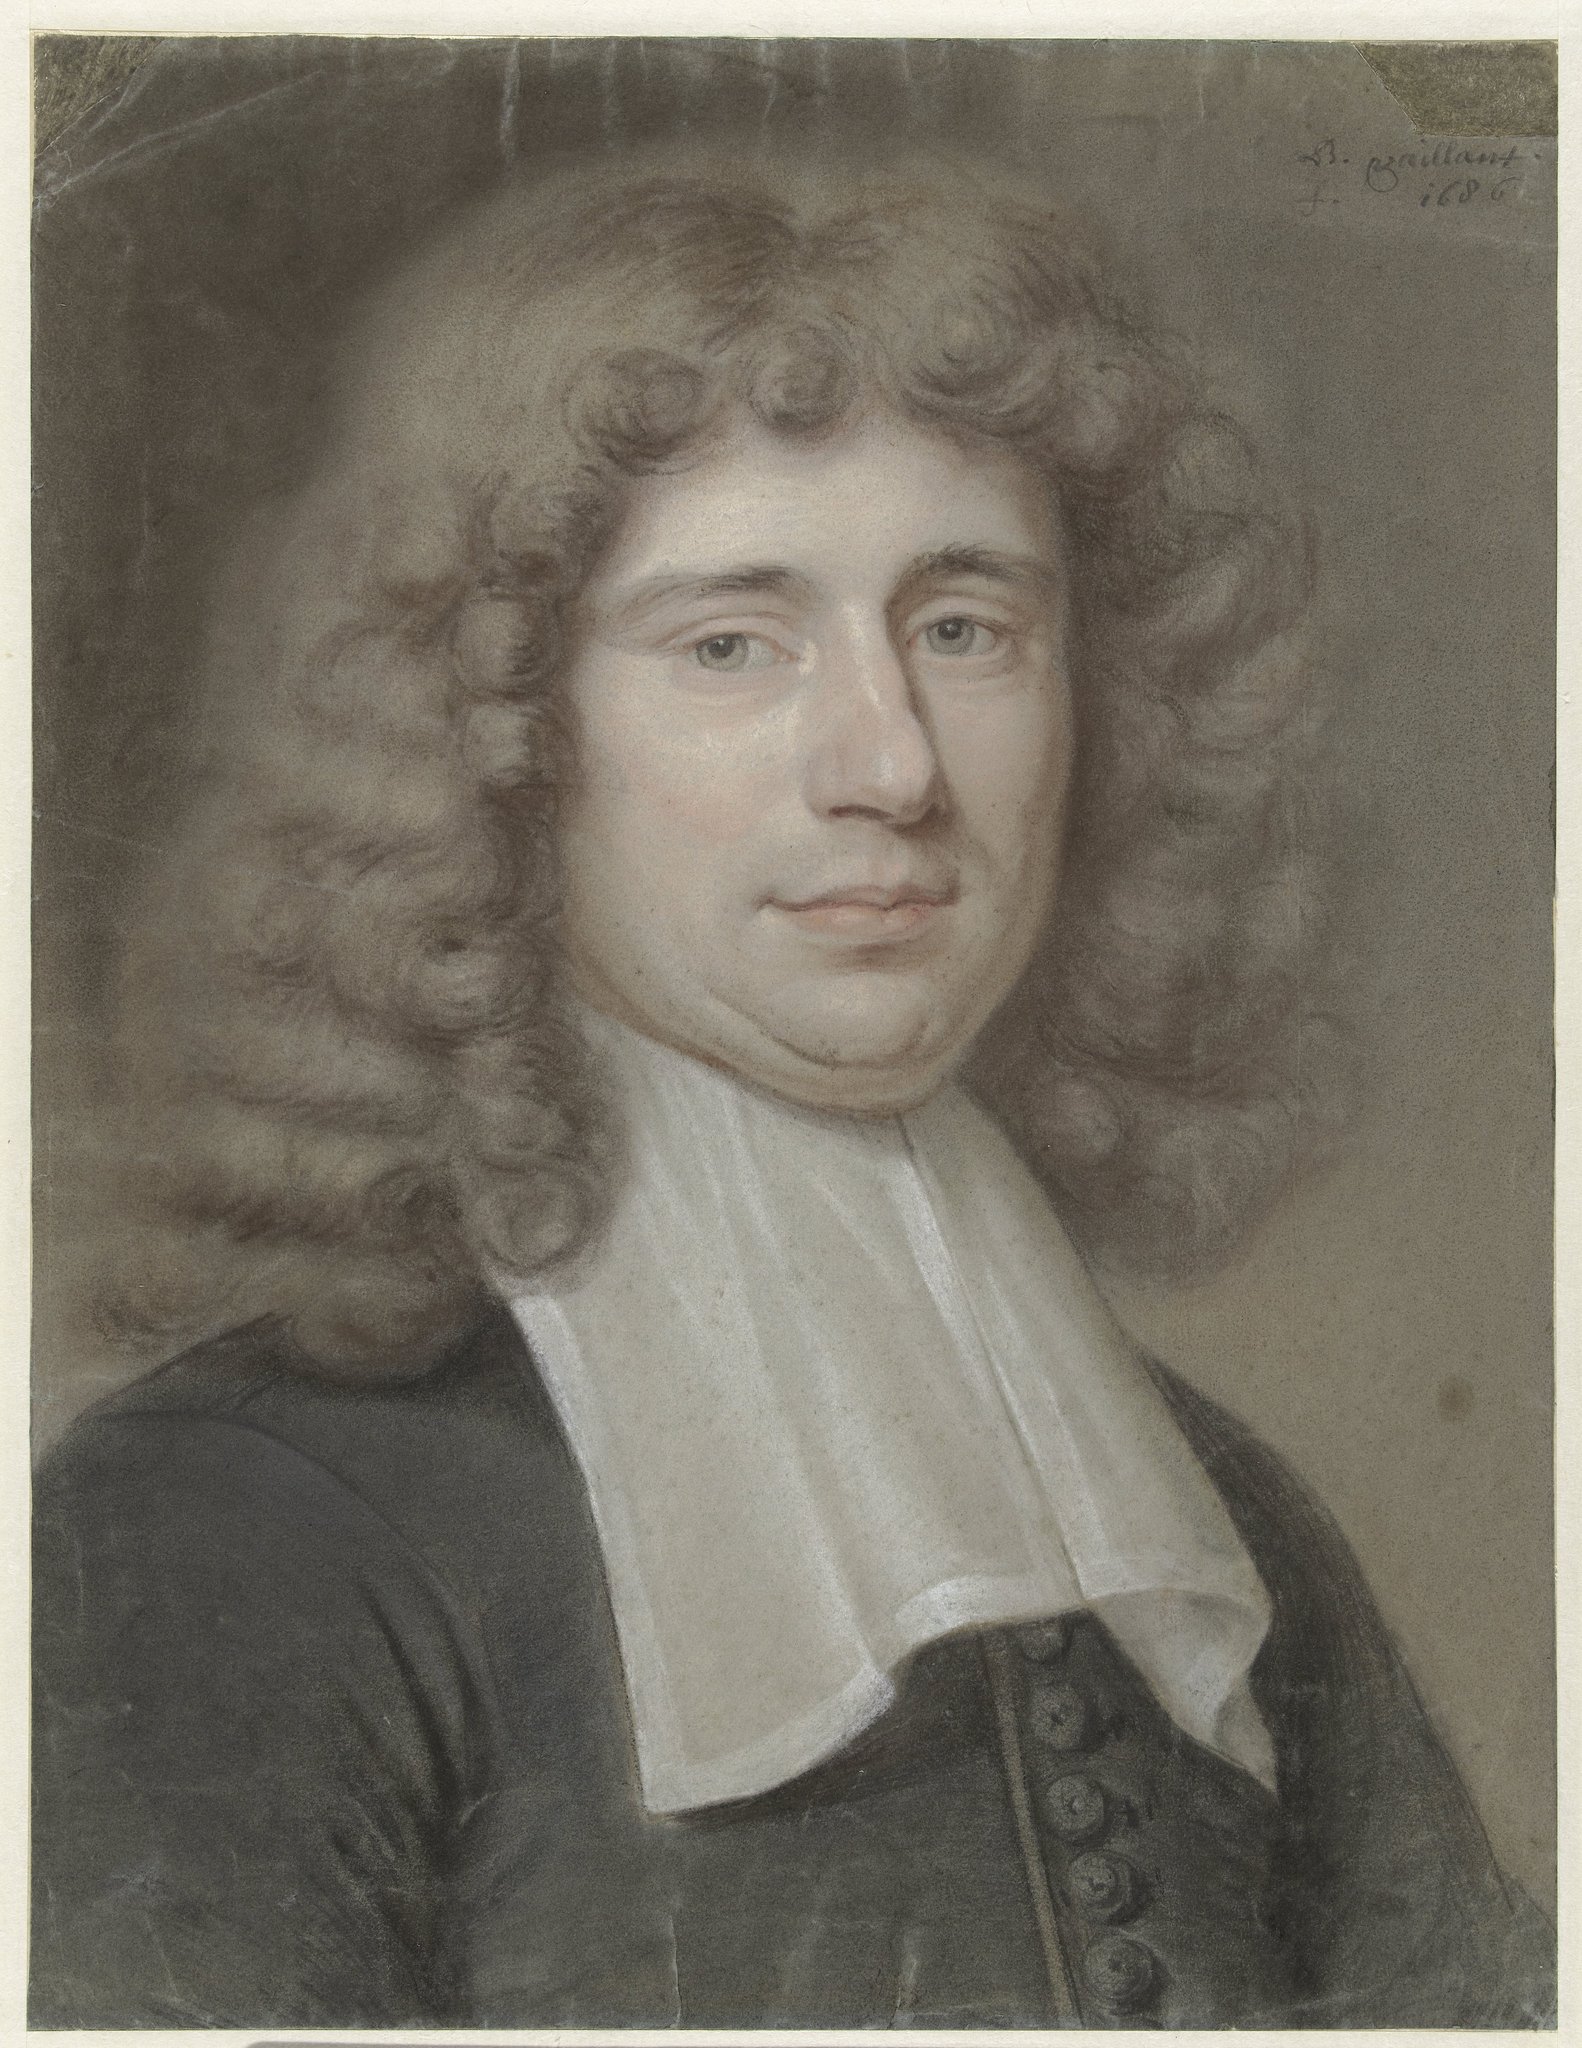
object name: drawing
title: Portret van een onbekende man, buste, naar rechts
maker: bernard vaillant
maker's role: draughtsman, painter, print maker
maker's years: 1632-1698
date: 1686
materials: paper, pastel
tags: anonymous historical person portrayed alone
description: Pendant van 'Portret van een onbekende vrouw, buste, naar links'.